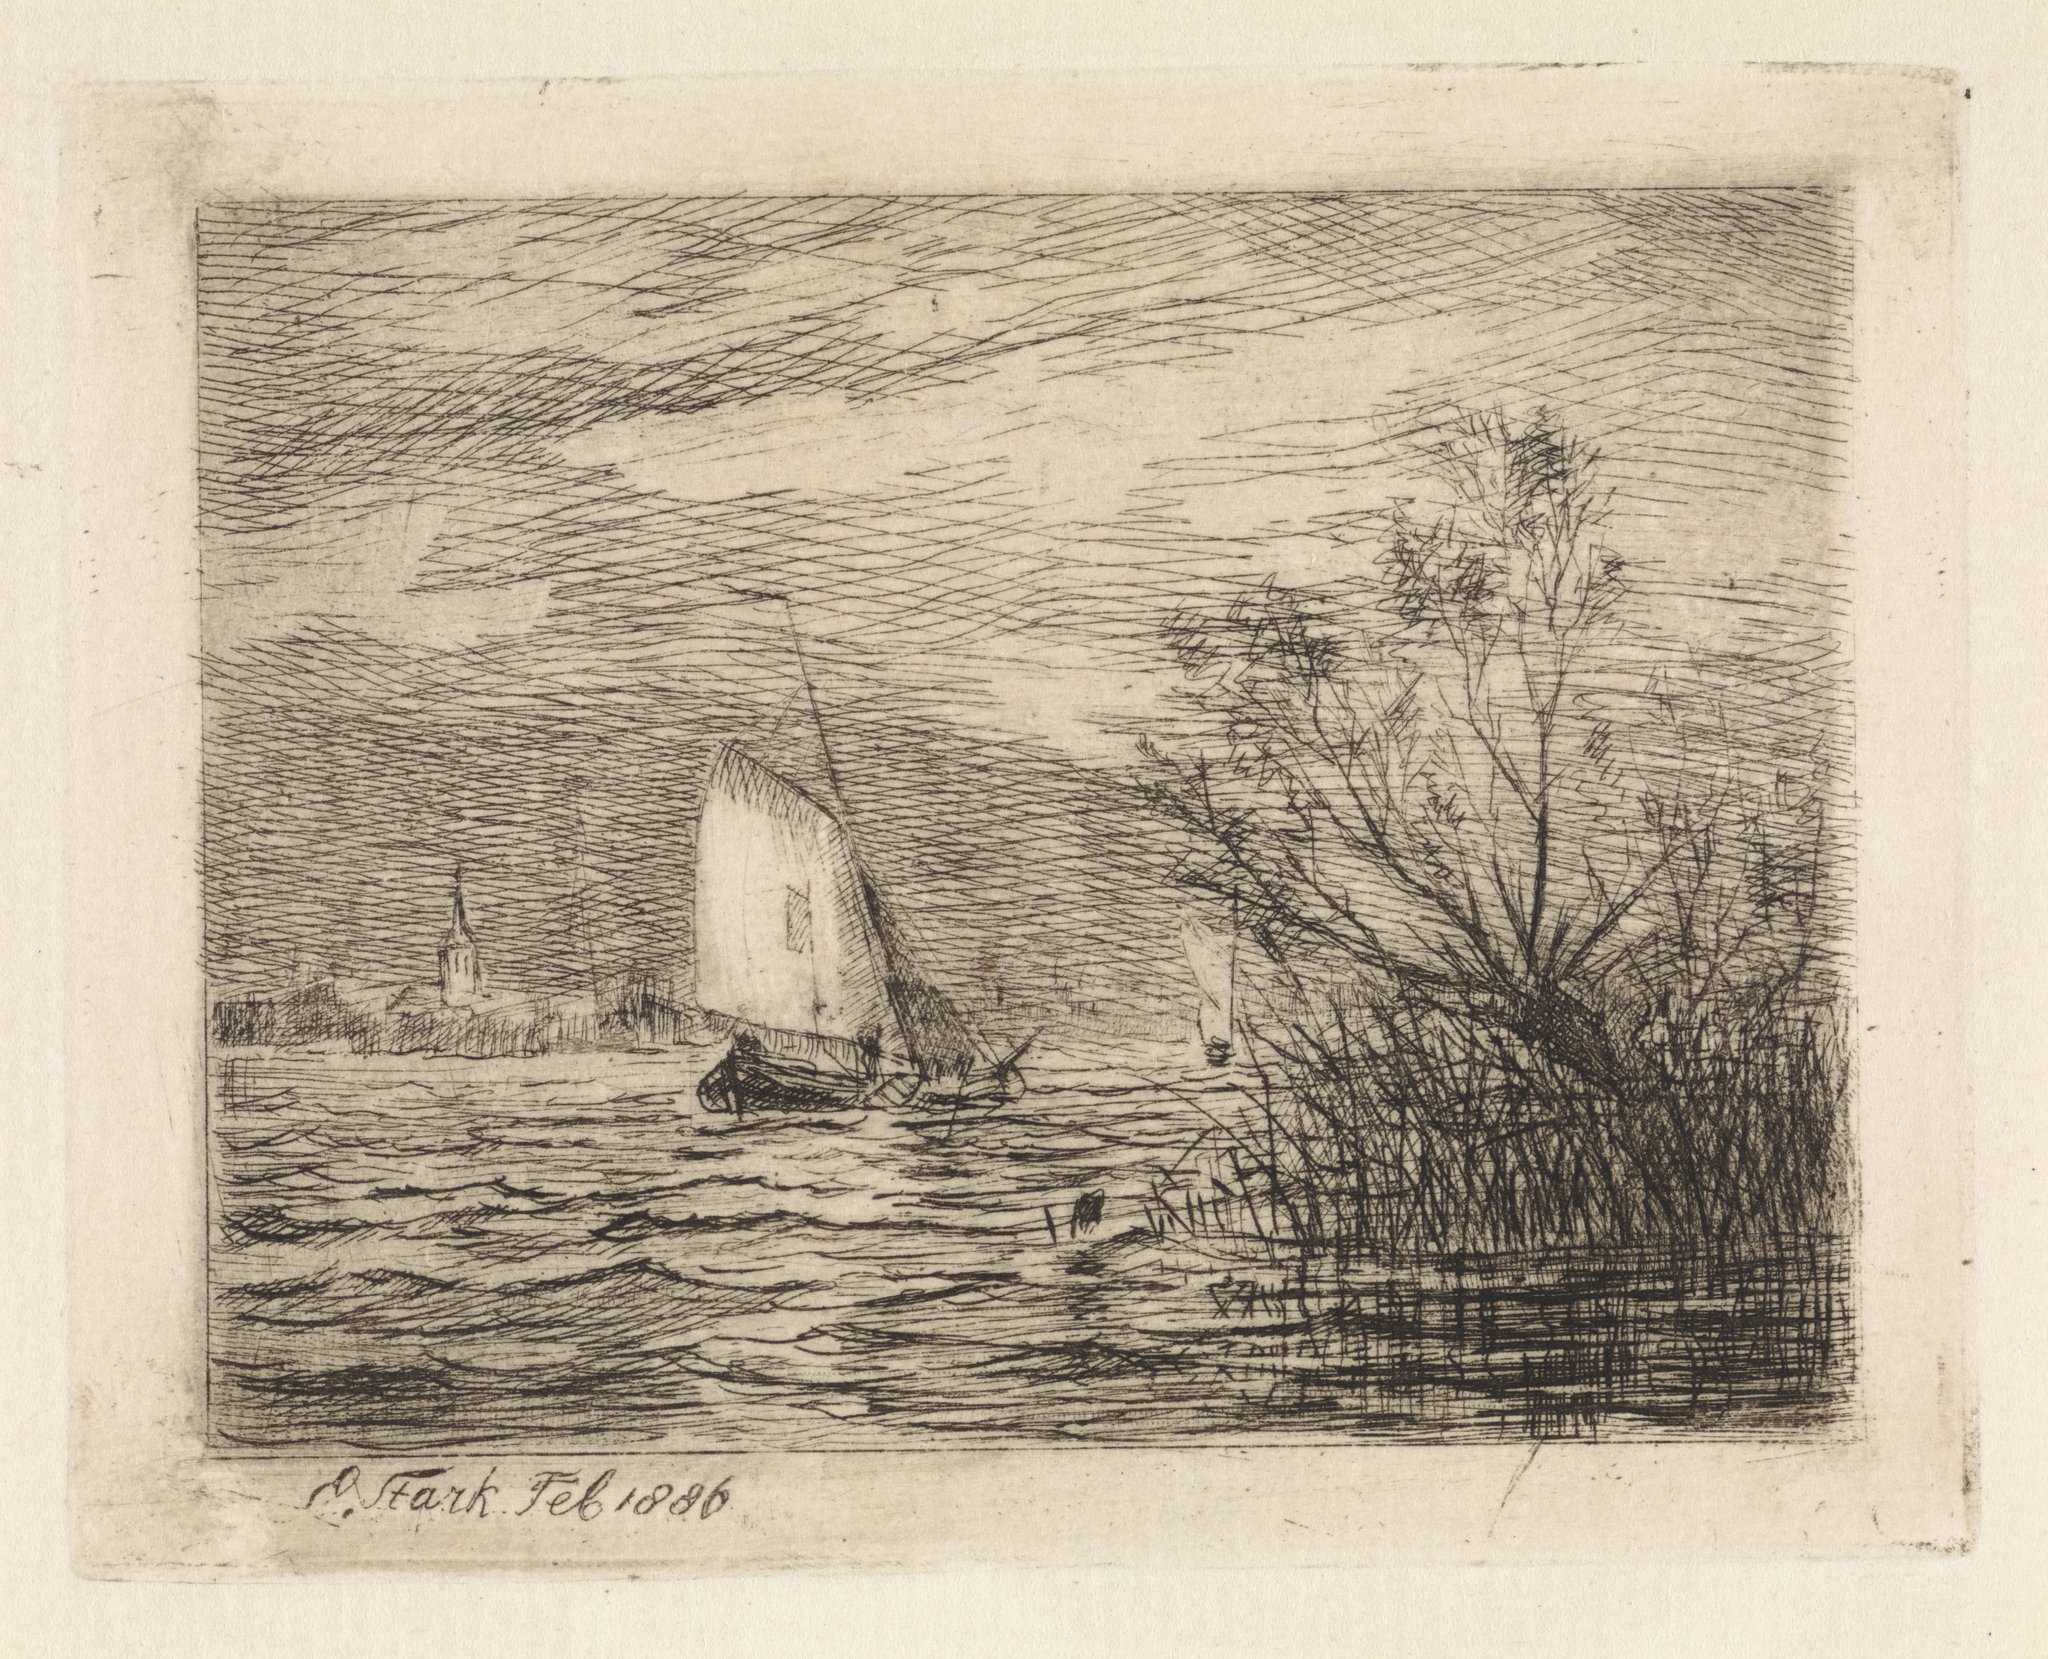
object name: print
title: Zeilschip op een rivier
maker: elias stark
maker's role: draughtsman, print maker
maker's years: 1849-1933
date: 1802-1886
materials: paper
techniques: etching, intaglio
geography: nieuwer-amstel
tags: sailing-ship, sailing-boat, river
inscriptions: collector's mark: Lugt 2228